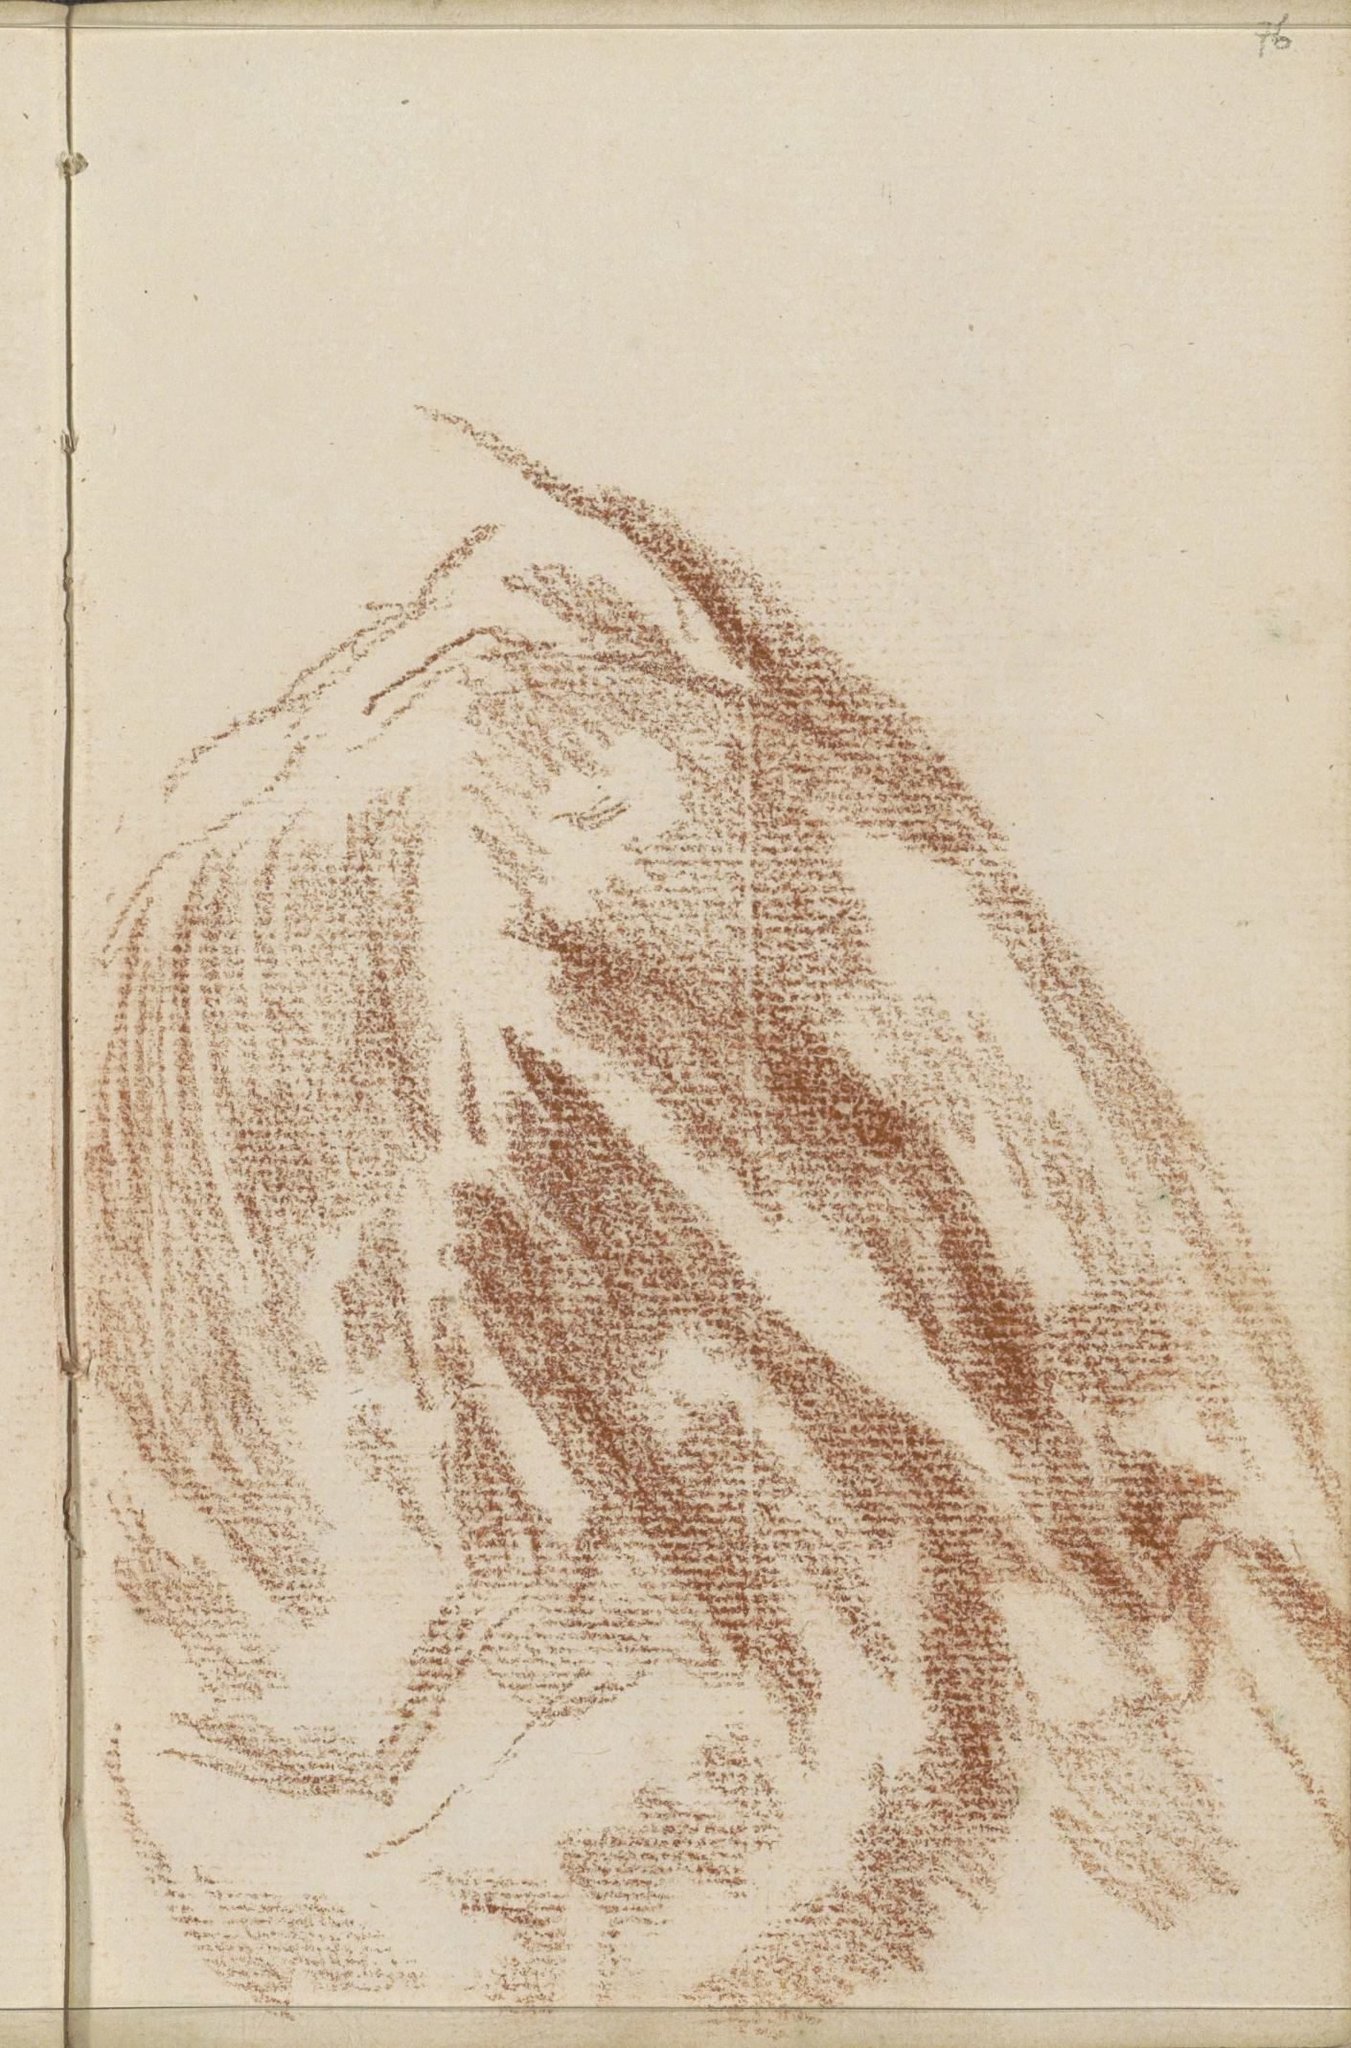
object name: sketchbook leaf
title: Draperie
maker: petrus johannes van reysschoot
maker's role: draughtsman, print maker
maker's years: 1702-1772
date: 1710-1772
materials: chalk, paper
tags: drapery, draped garment, 'gewandgebung'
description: Blad 76 recto uit een schetsboek met 105 bladen.